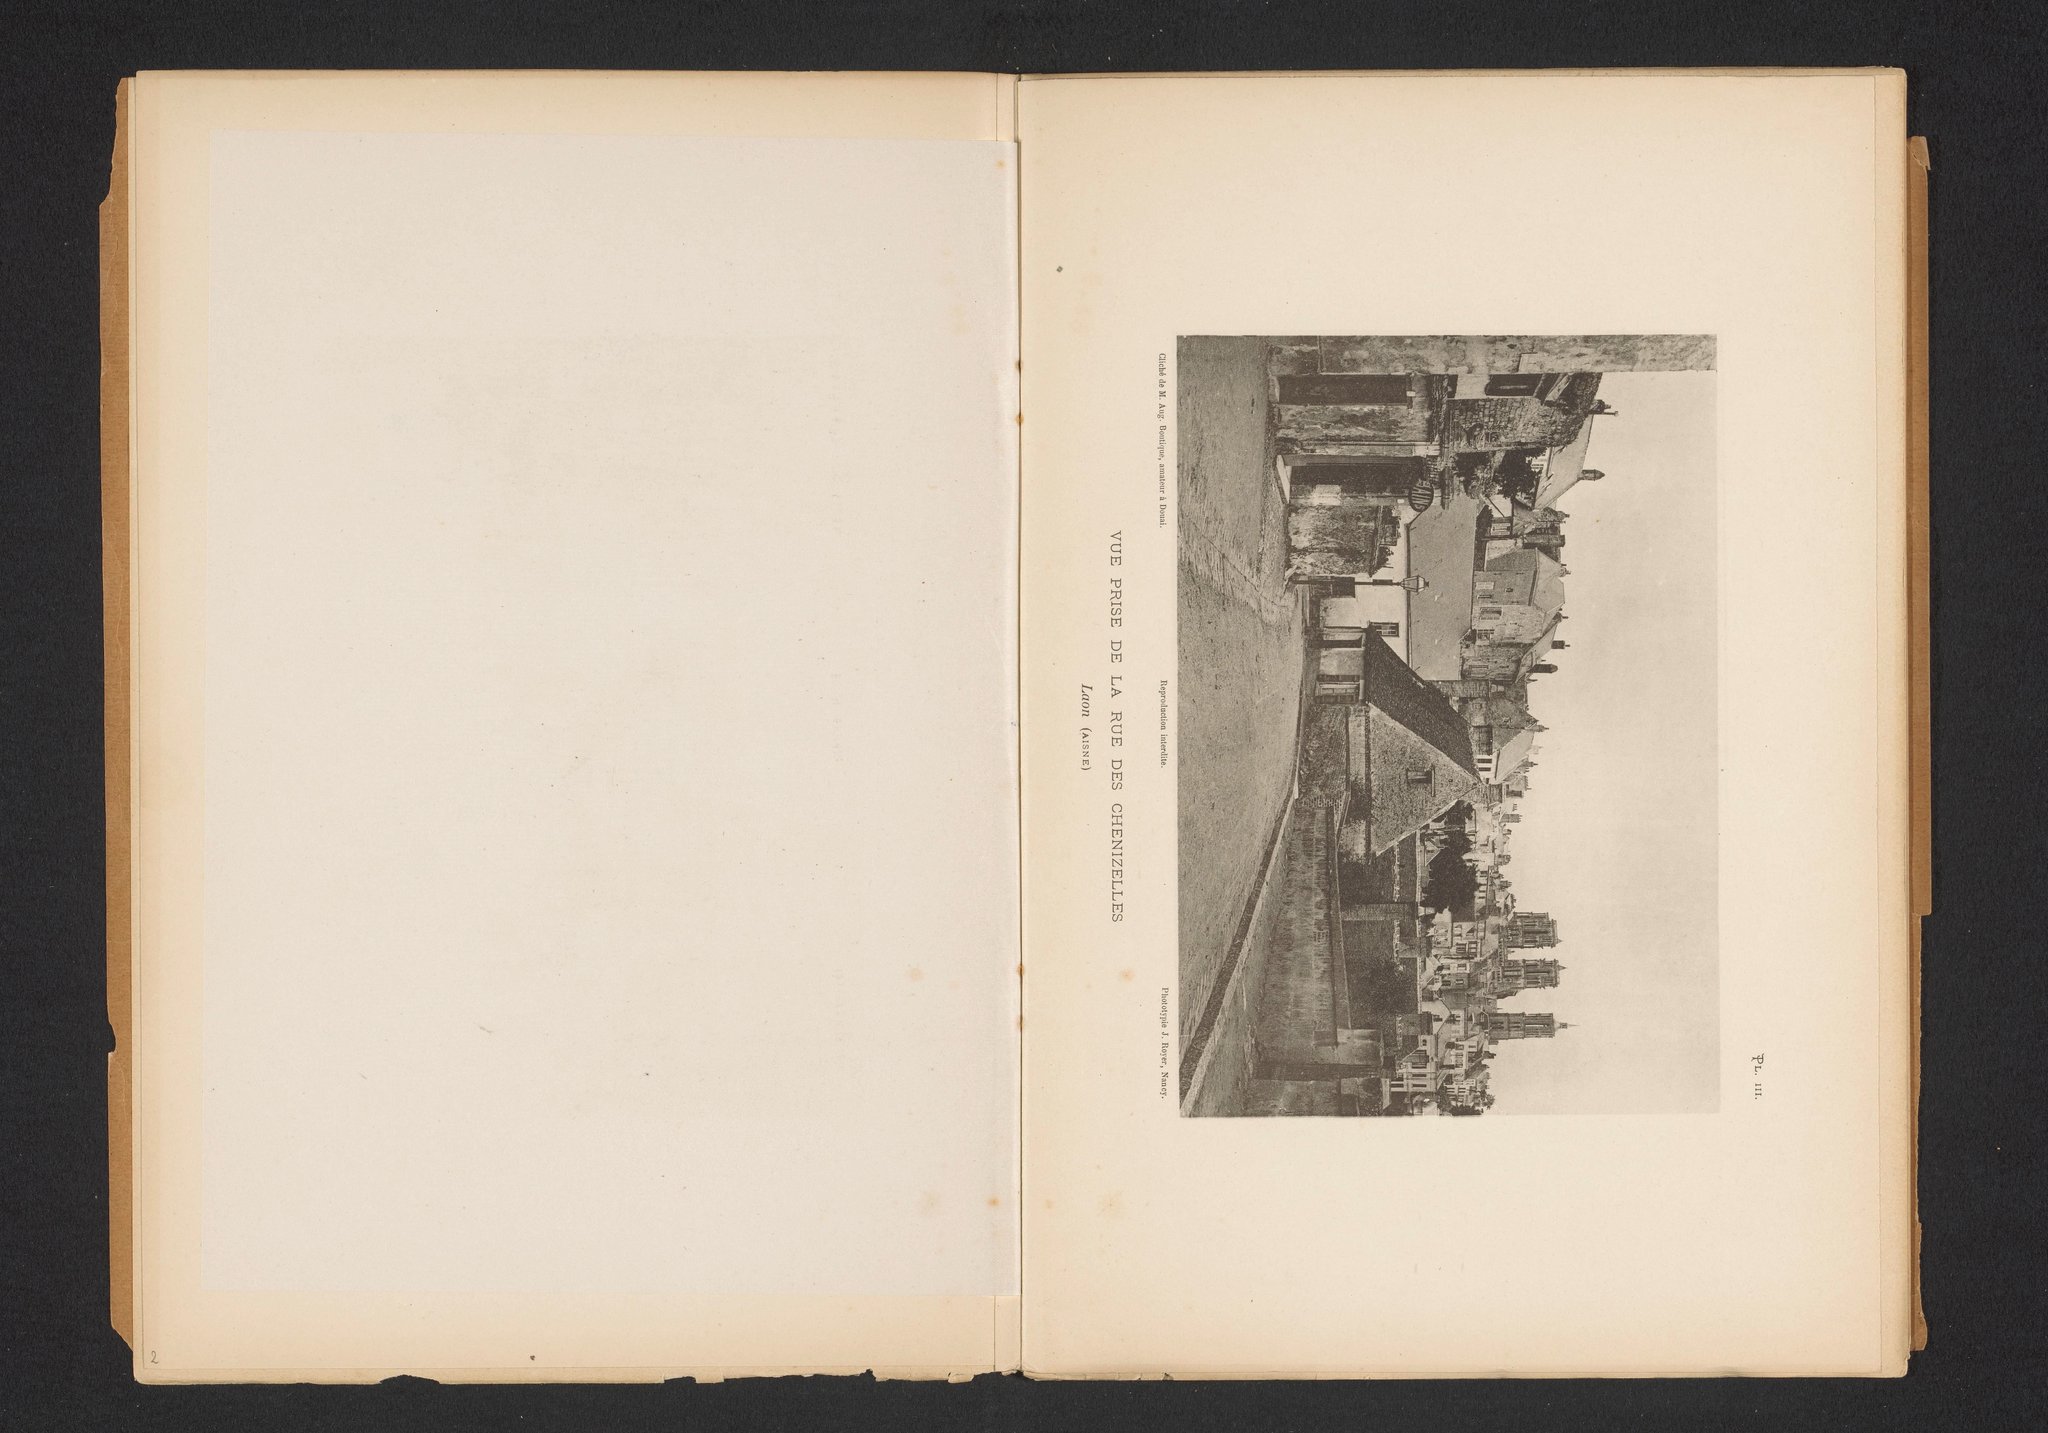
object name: page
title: Vue Prise de la Rue de Chenizelles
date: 1891-1896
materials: paper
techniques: photograph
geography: douai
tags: street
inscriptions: inscription: ‘Reproduction interdite.’, number: ‘Pl. III.’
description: Prent op derde ongenummerde pagina na pagina 2.